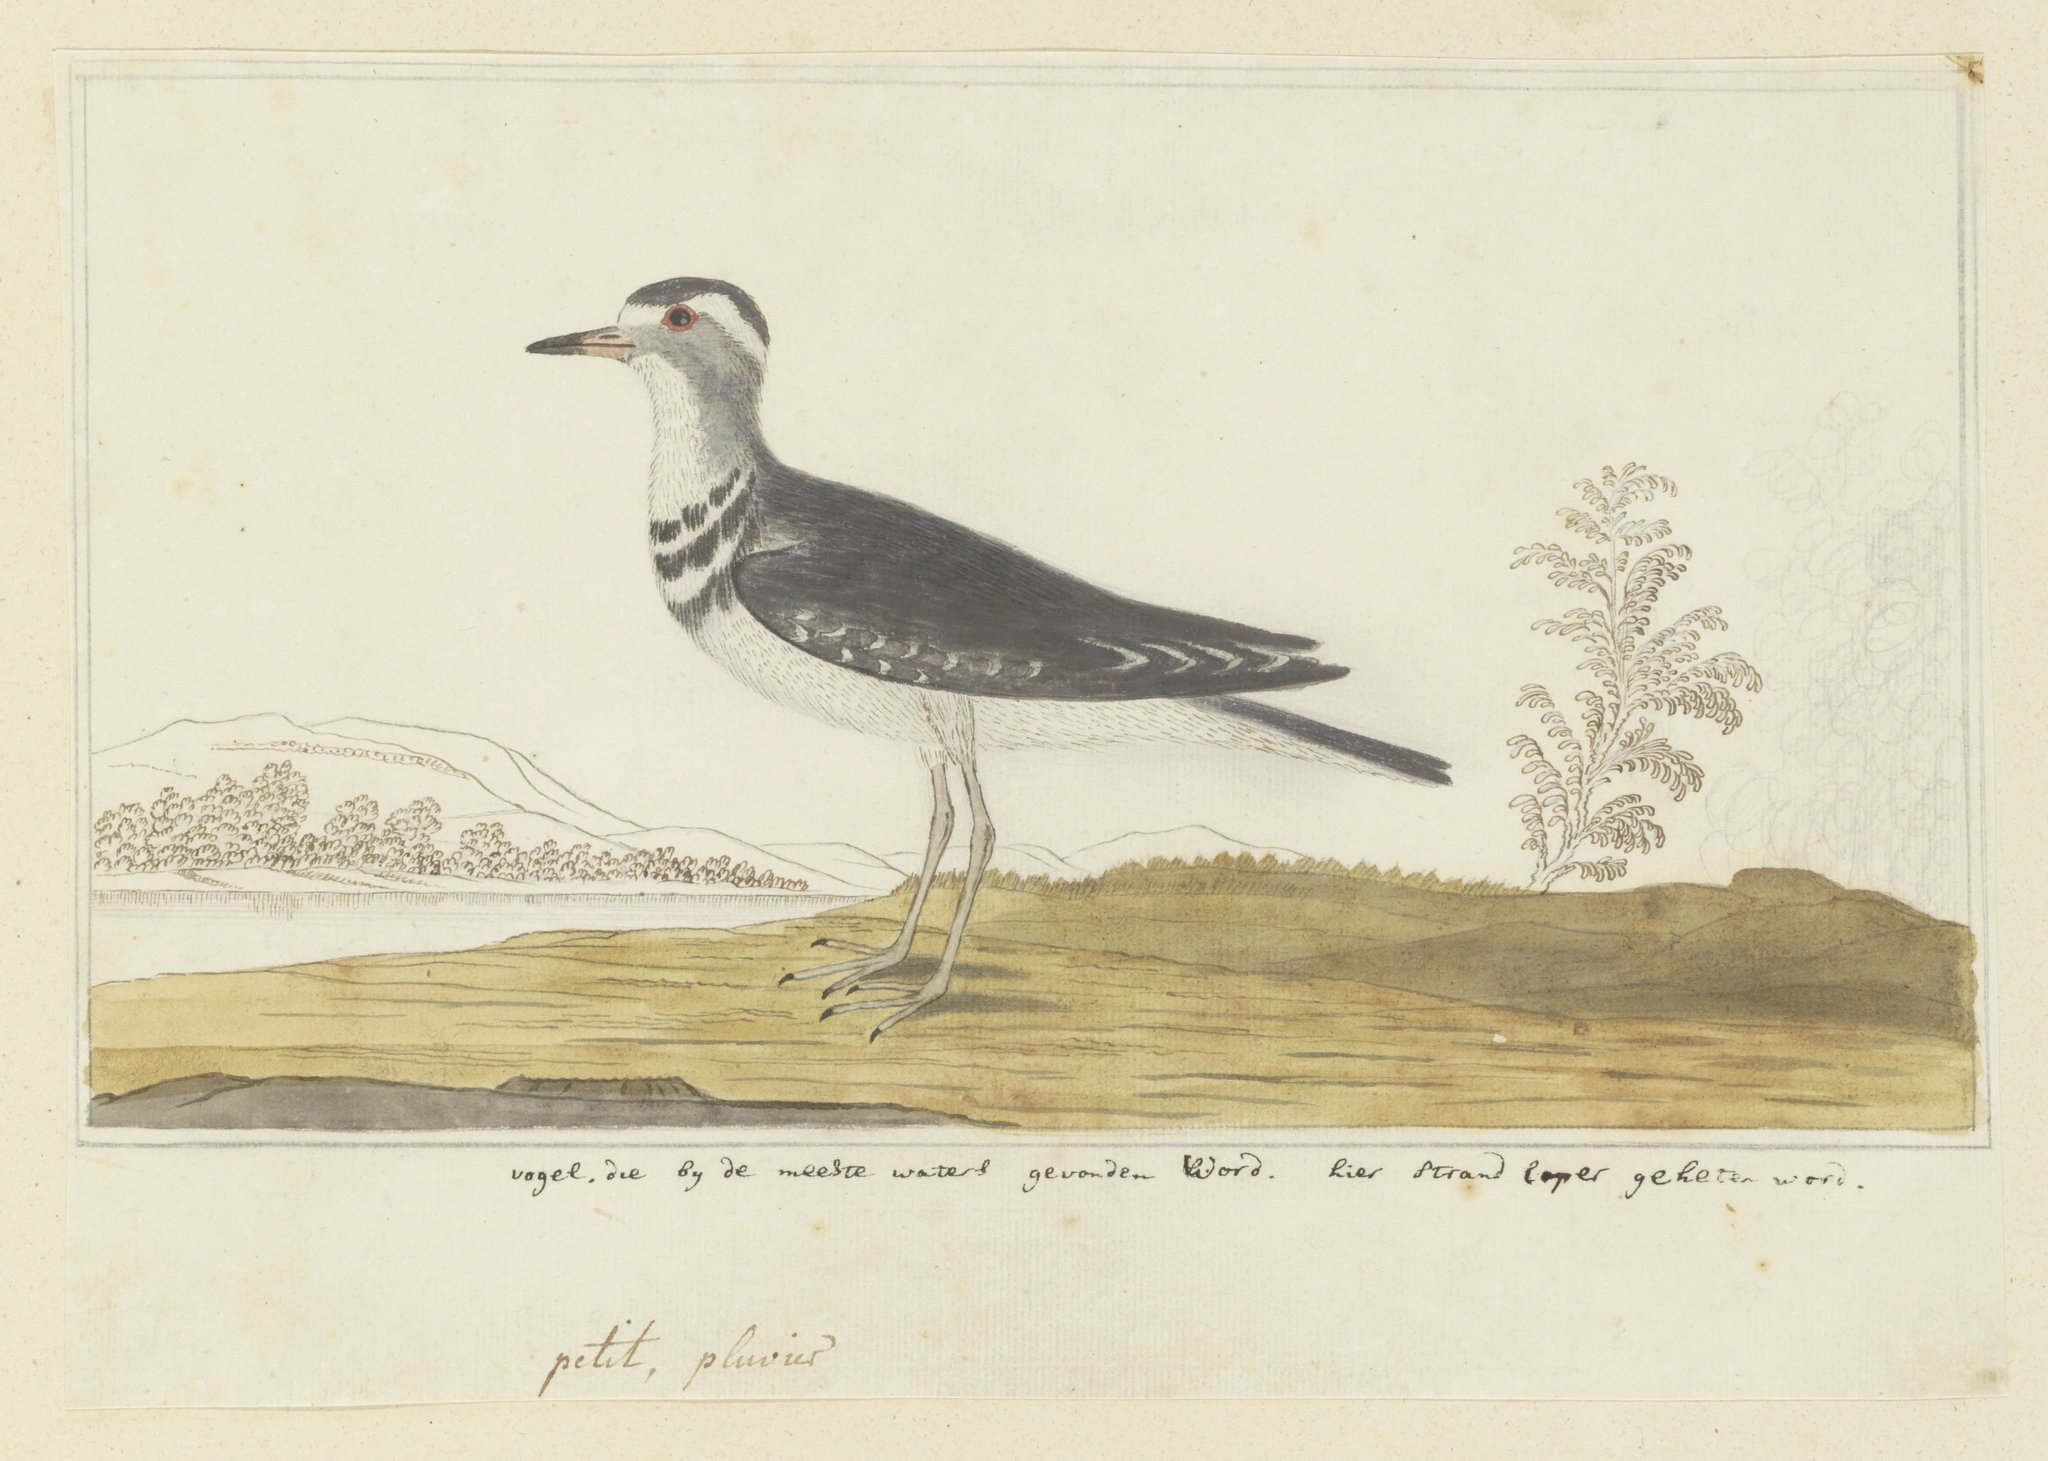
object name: album leaf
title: Charadrius tricollaris (Three-banded sandplover)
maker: robert jacob gordon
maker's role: draughtsman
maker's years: 1743-1795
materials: chalk, ink, paper, pencil, watercolor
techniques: brush, pen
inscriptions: annotation: ‘vogel, die bij de meeste waters gevonden word. hier strand loper geheten word. / petit, pluvier’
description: Vogelstudie: Driebandzandloper (Charadrius tricollaris).